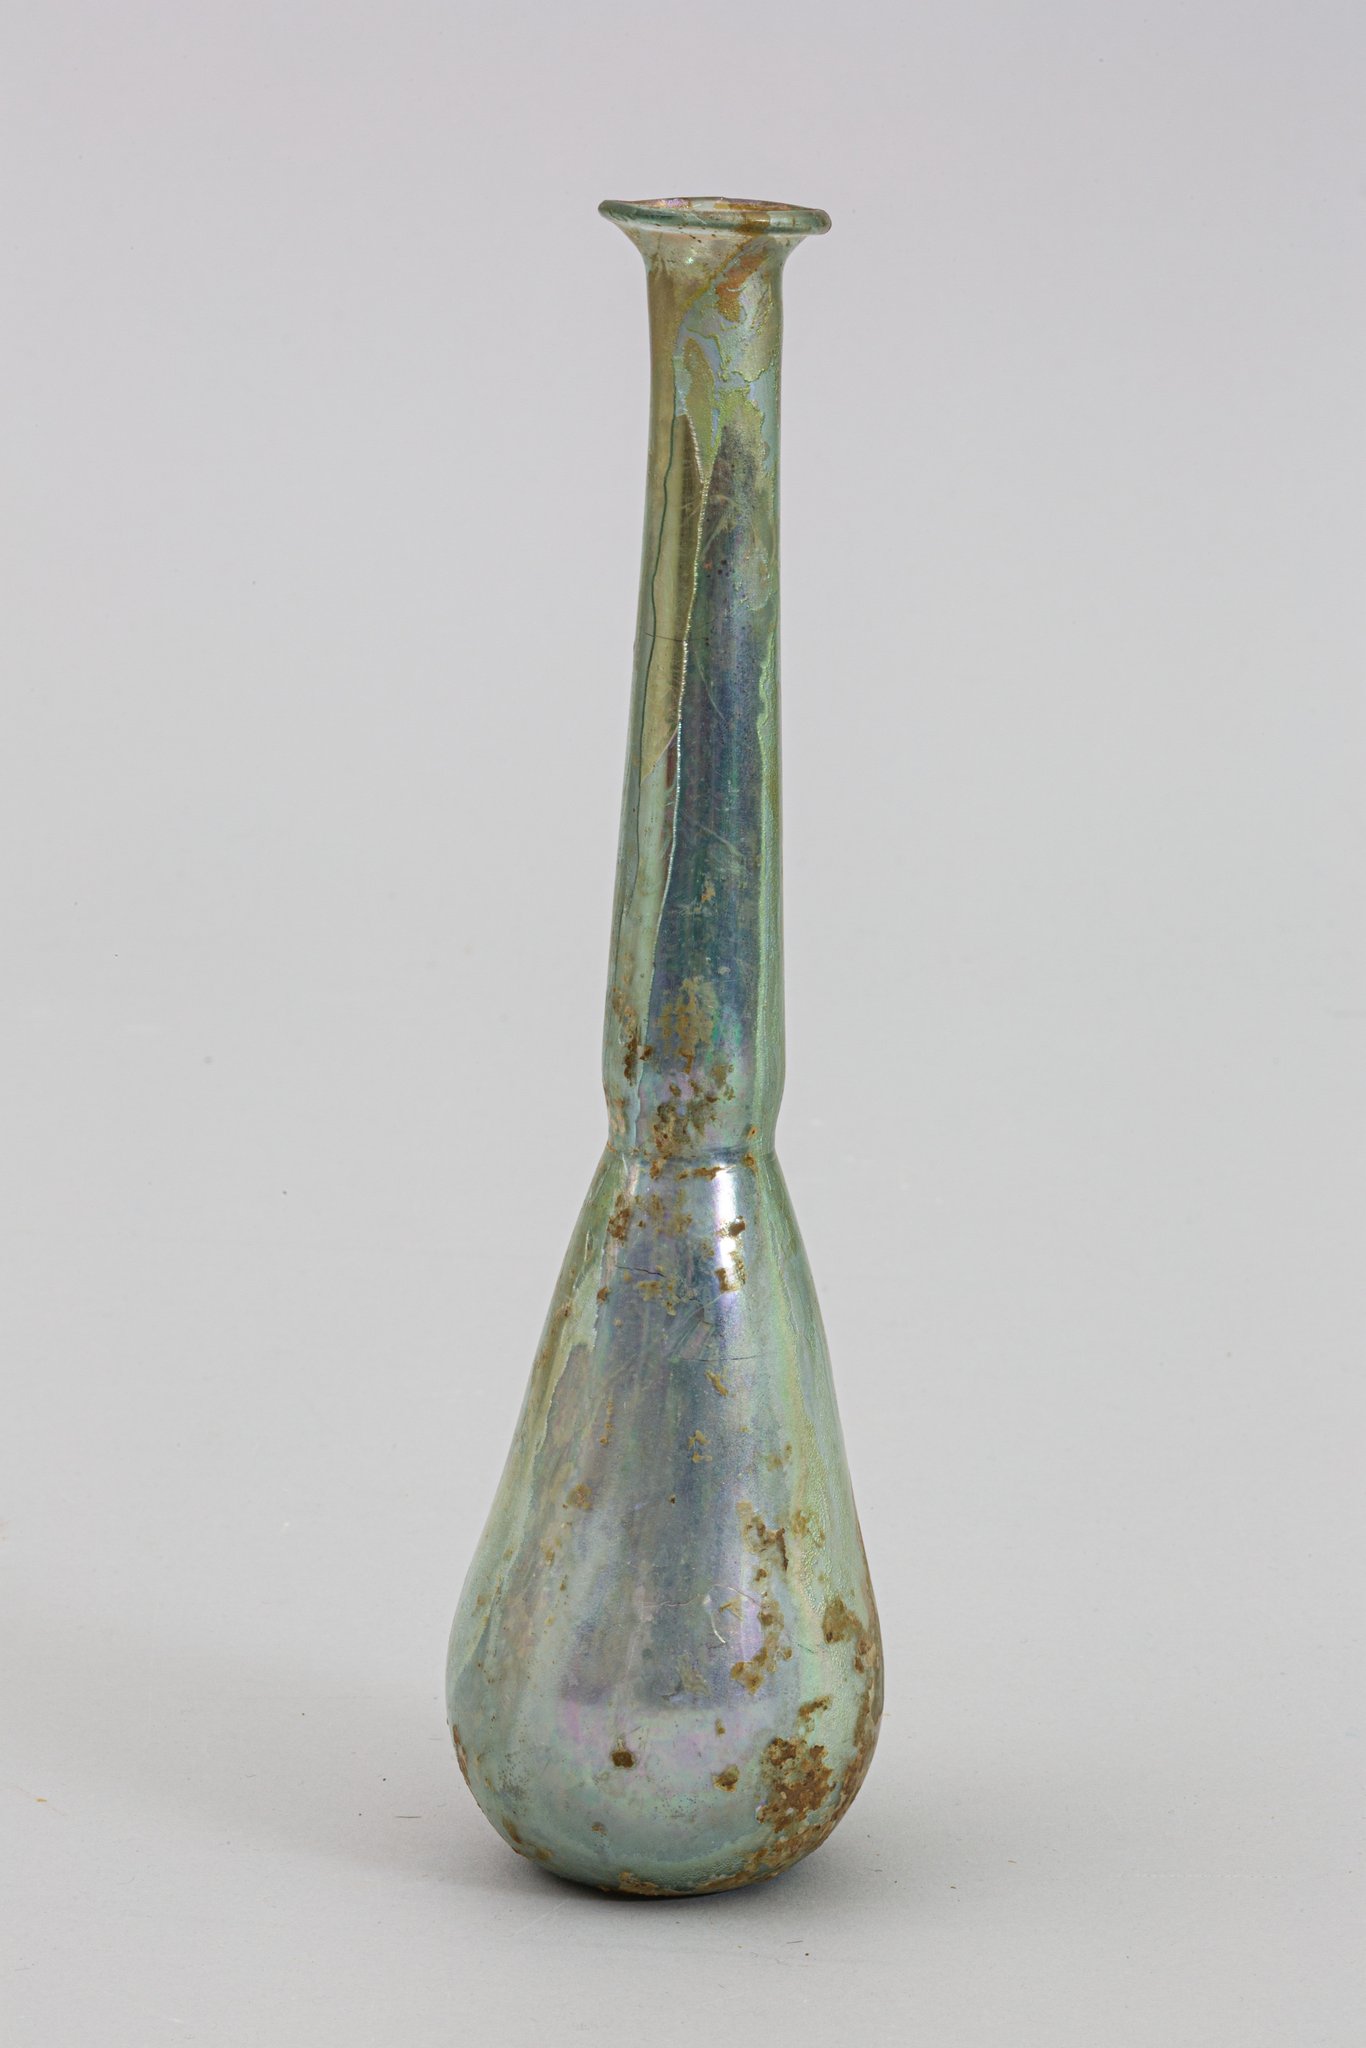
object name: perfume bottle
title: Glass perfume bottle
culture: roman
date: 67-200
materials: glass